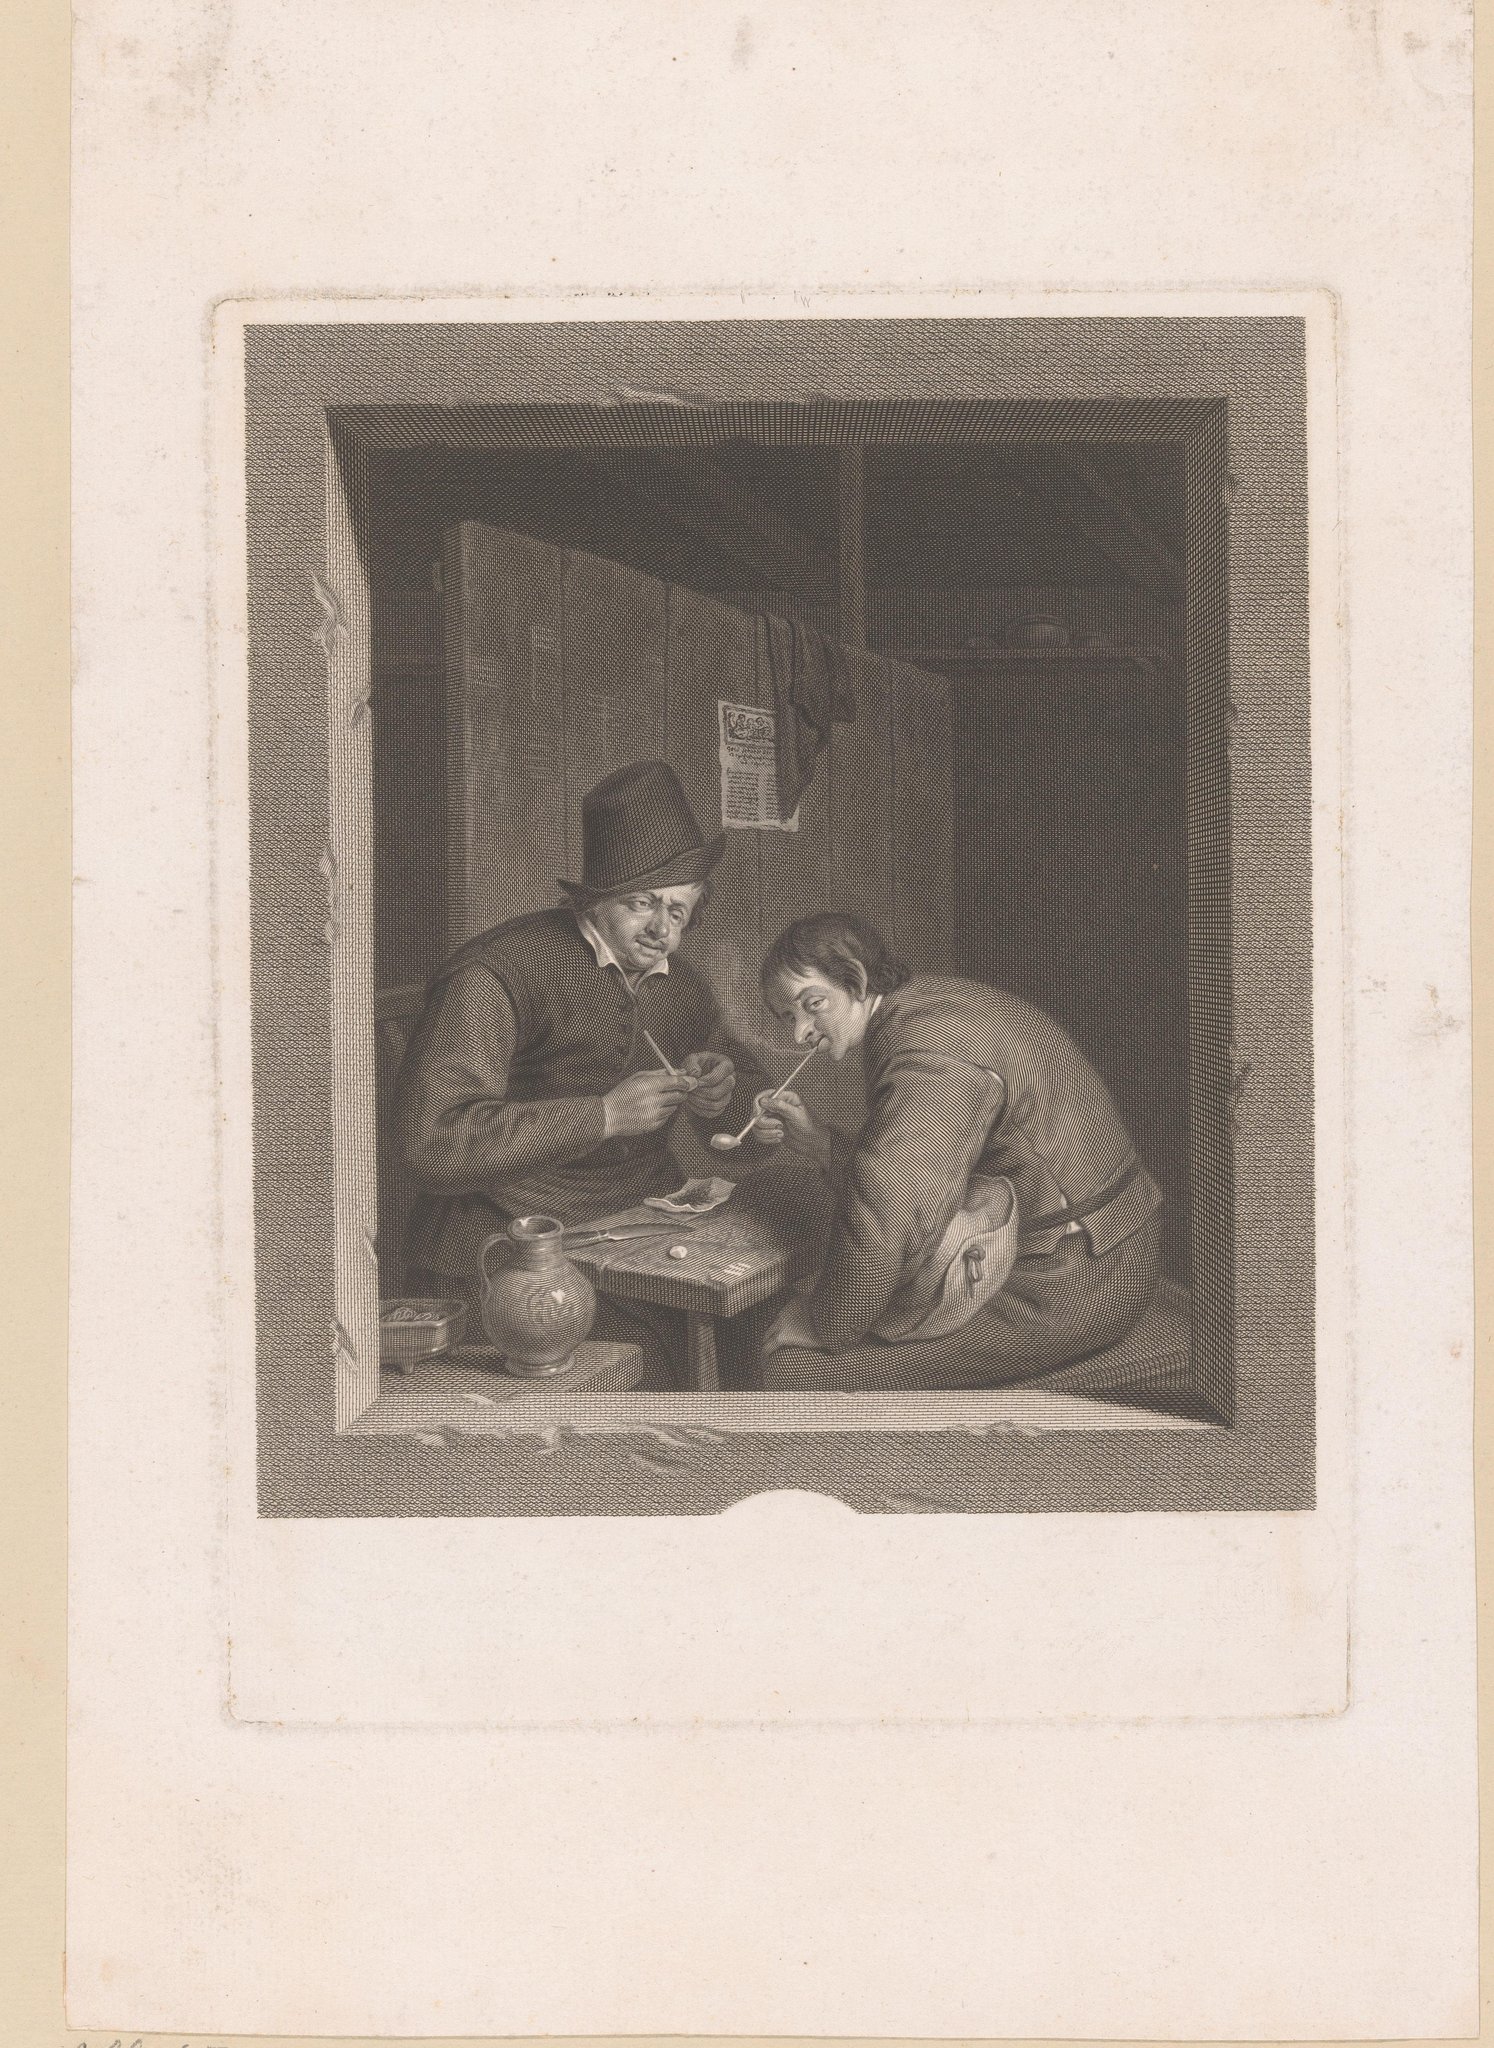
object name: print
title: Twee pijprokende mannen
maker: johann georg wille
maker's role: draughtsman, print maker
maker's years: 1715-1808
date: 1773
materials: paper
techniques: engraving, etching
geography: paris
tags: pipe ~ tobacco, interior of the house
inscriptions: collector's mark: Lugt 240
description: Deze prent maakt deel uit van een serie van onbekende omvang naar Nederlandse en Duitse schilderijen. Op sommige prenten staat linksboven aangegeven welk nummer in de serie het betreft.